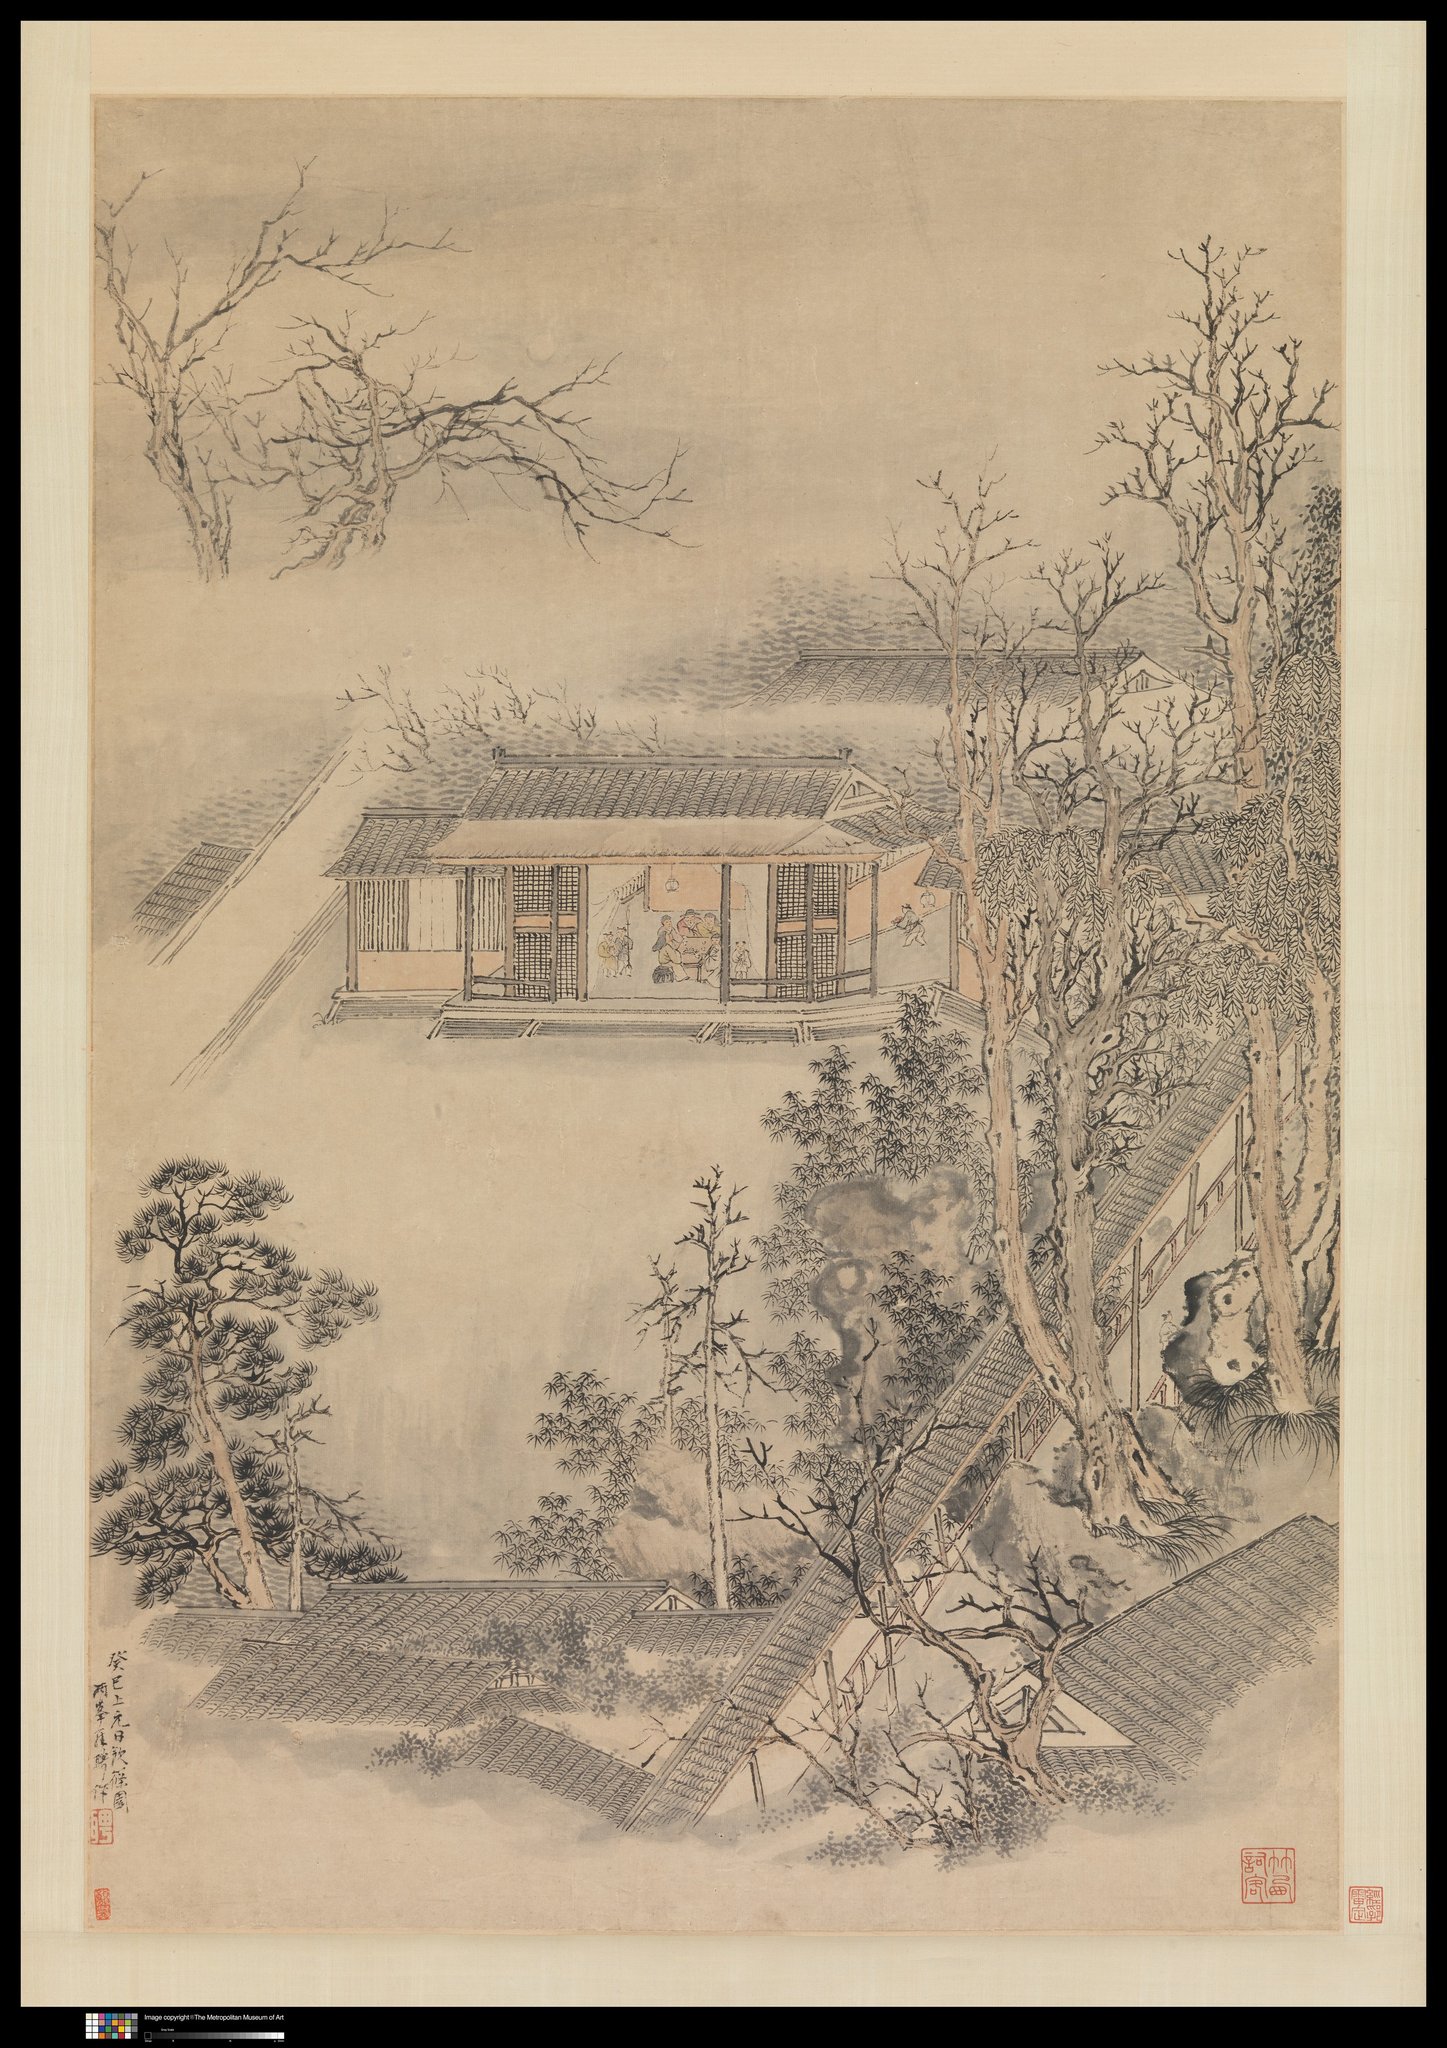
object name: hanging scroll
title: Drinking in the Bamboo Garden on the Lantern Festival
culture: chinese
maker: luo ping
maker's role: artist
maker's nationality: chinese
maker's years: 1733-1799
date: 1773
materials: ink, paper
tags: gardens,drinking